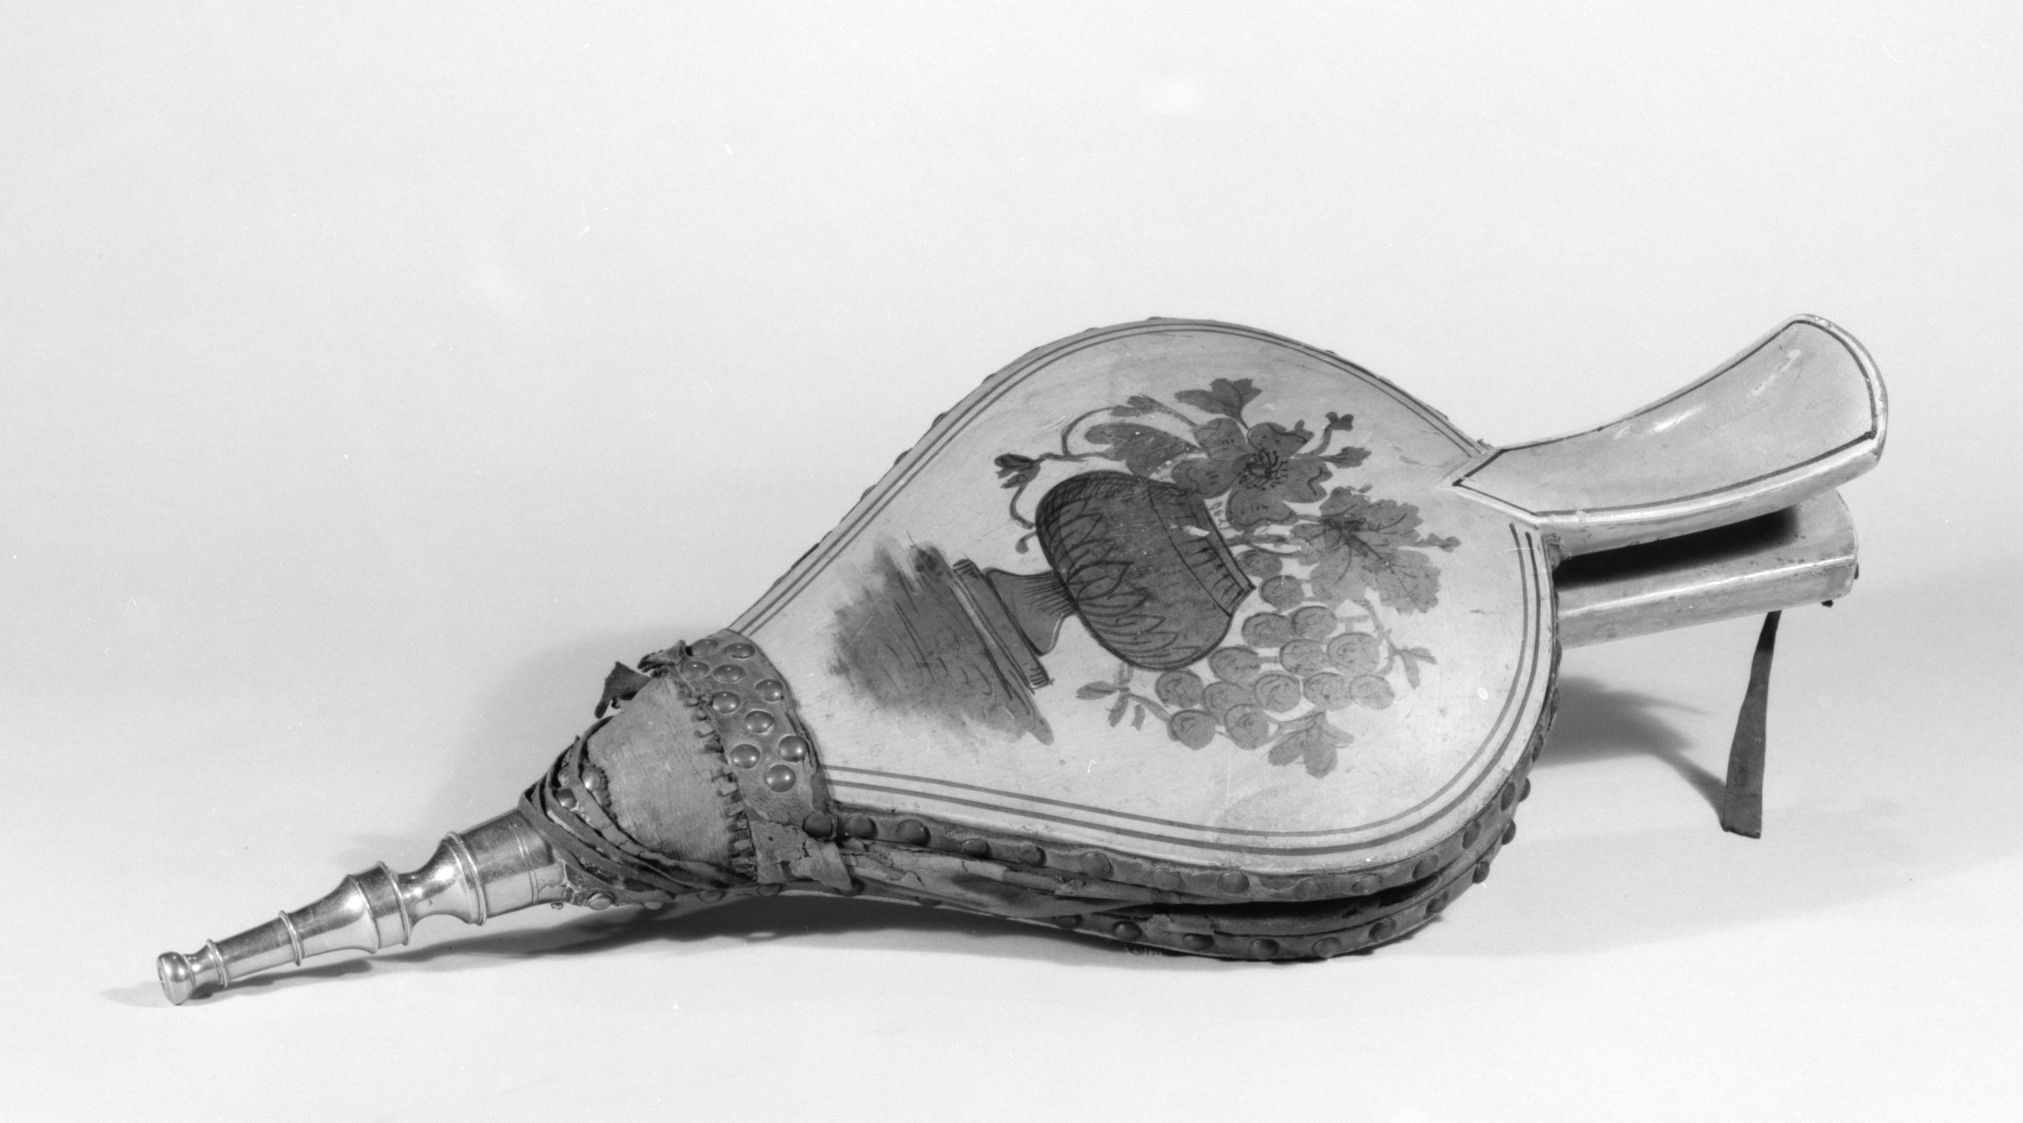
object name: bellow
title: Bellows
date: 1800-1830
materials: brass, leather, wood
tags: flowers